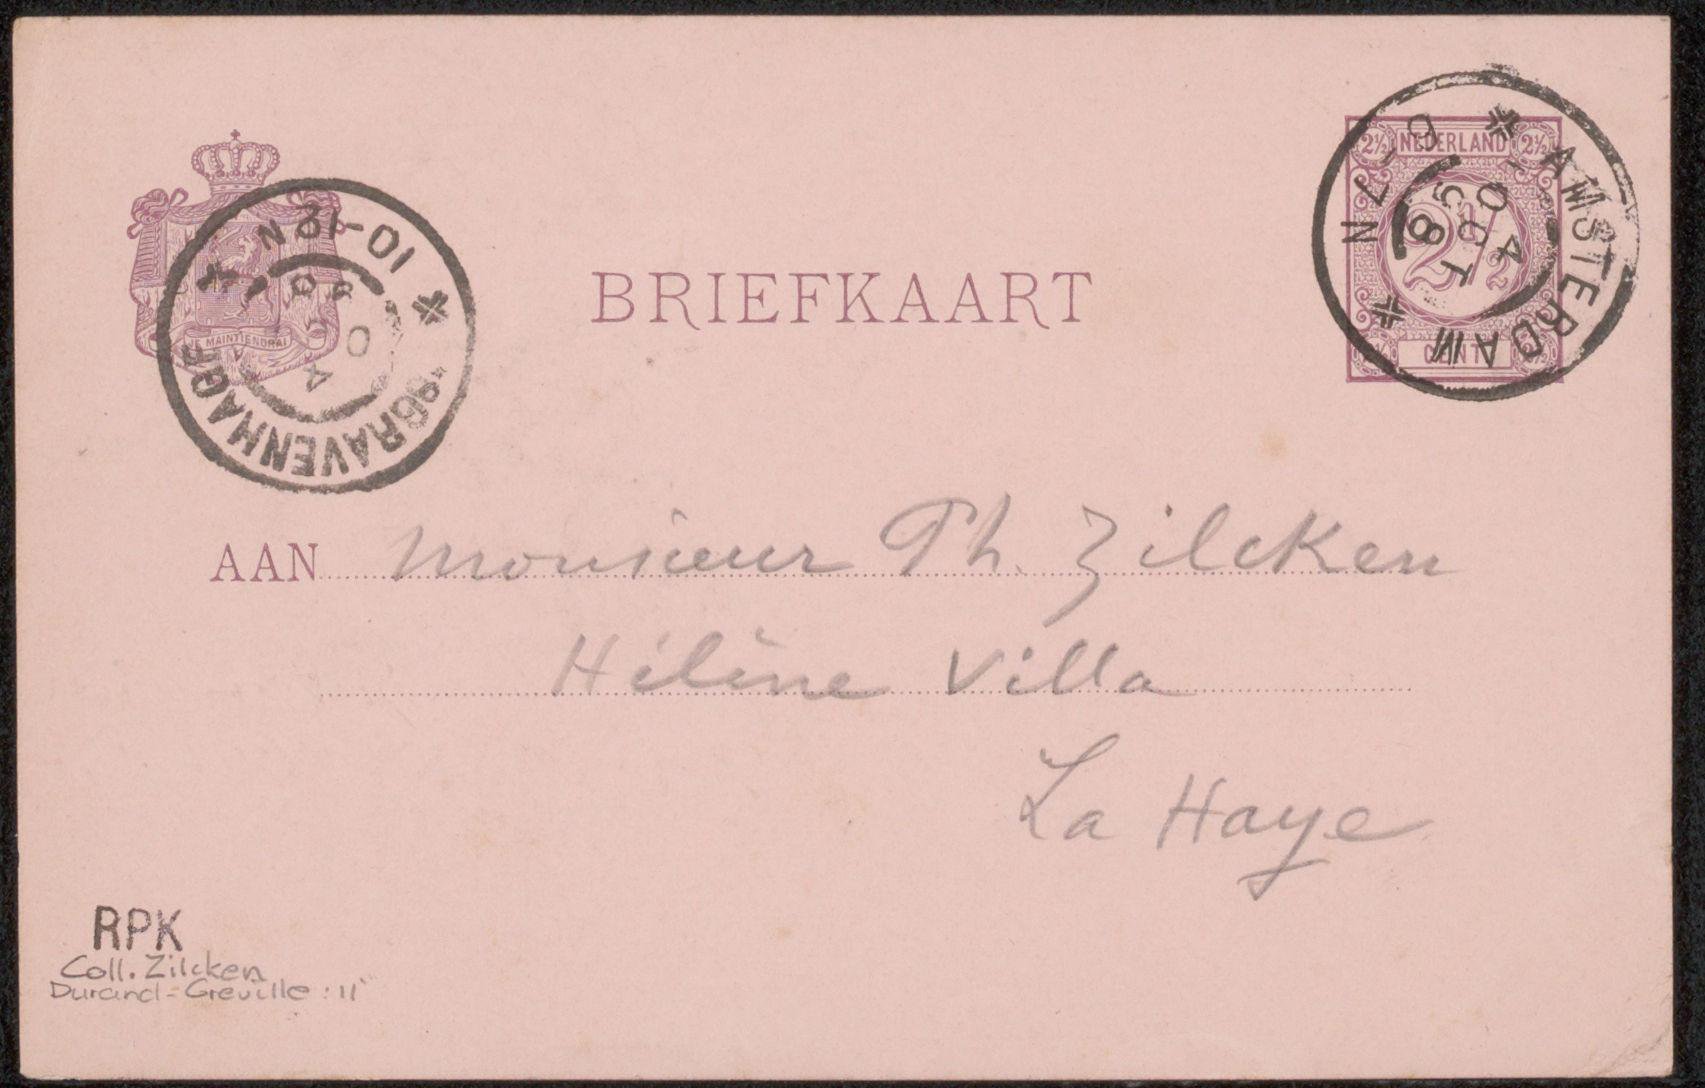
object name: postcard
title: Briefkaart aan Philip Zilcken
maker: émile durand-gréville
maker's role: schrijver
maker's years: 1838-1914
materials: cardboard, pencil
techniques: writing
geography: amsterdam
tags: the hague, painter, draughtsman, philip zilcken, painting (including book-illumination, miniature-painting), amsterdam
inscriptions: collector's mark: ‘RPK’